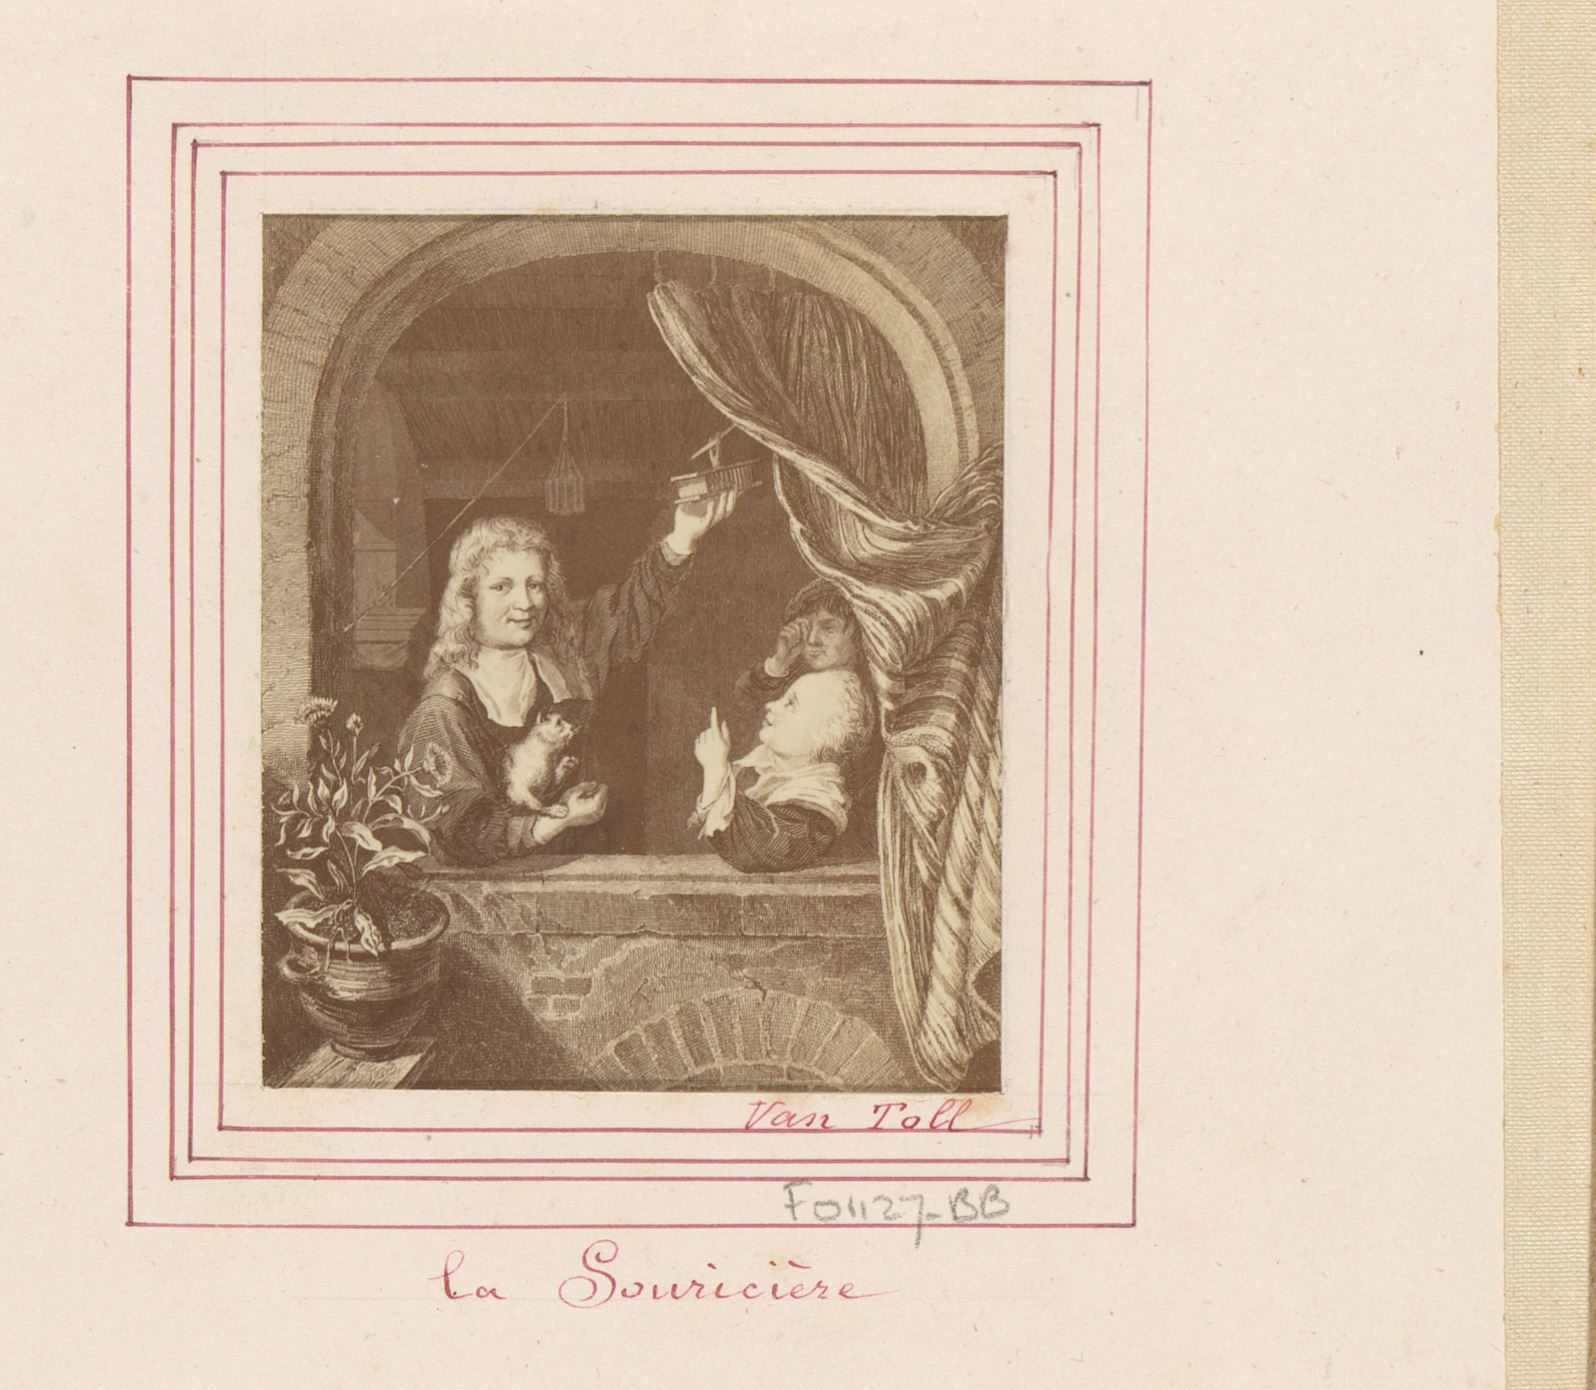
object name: photograph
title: Fotoreproductie van (vermoedelijk) een prent naar het schilderij Kinderen met een muizenval door Domenicus van Tol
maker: Anonymous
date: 1865-1875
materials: photographic support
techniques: albumen print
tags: eradication of mice, child, mouse trap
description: Onderdeel van Album met foto's en litho's van bezienswaardigheden in Noord- en Zuid-Hollandse steden, schilderijen en klederdrachten.